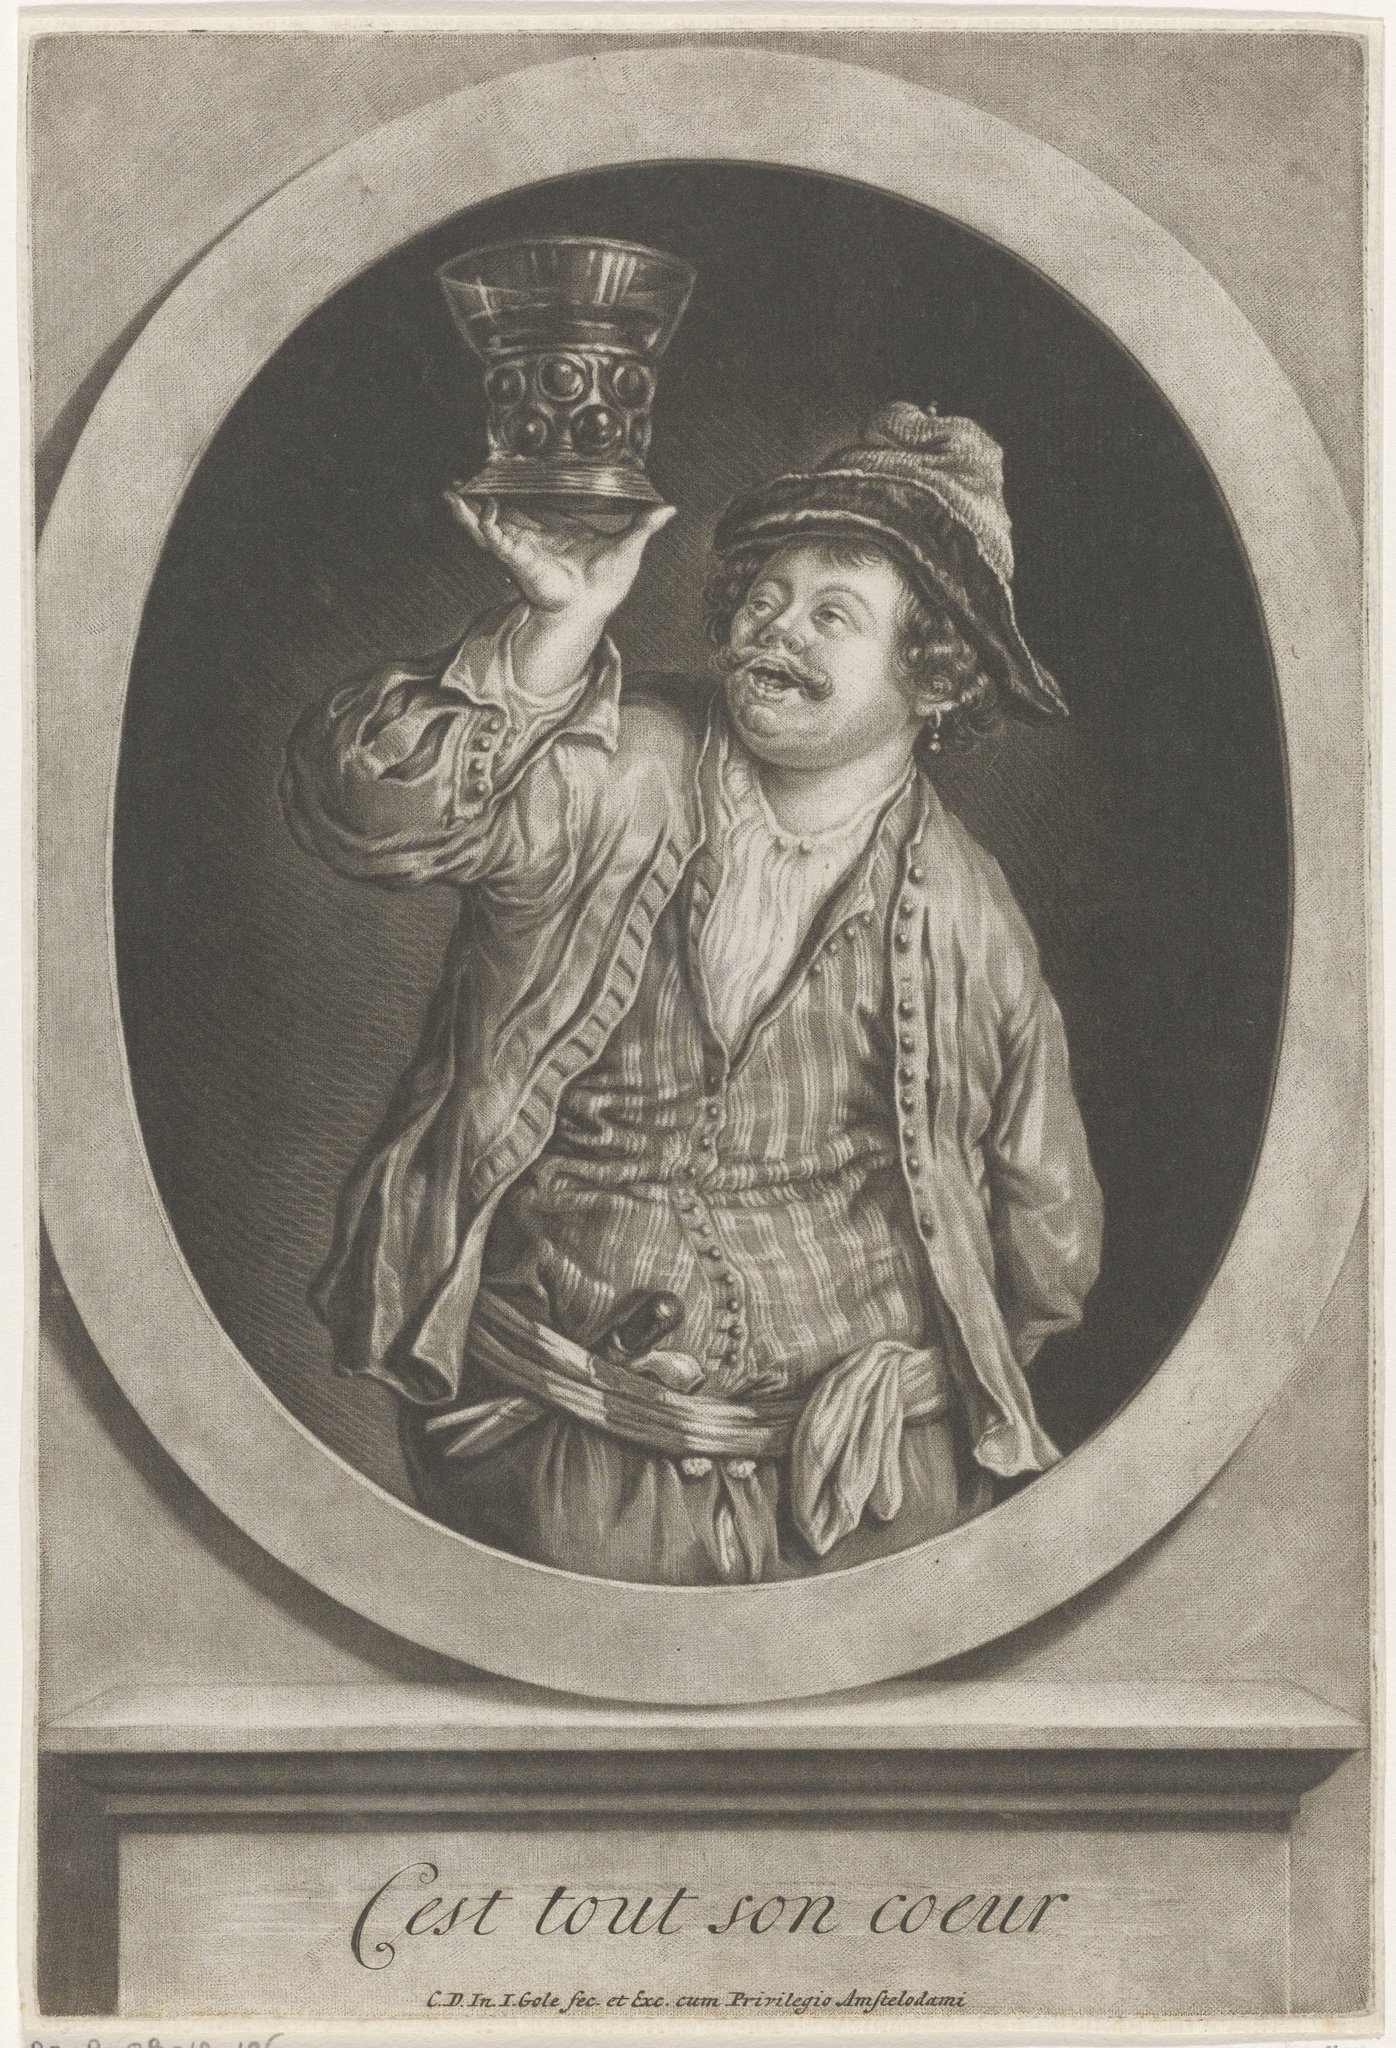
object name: print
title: Man met een roemer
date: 1670-1724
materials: paper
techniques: engraving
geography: amsterdam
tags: rome, painter, draughtsman, jan van mieris, head-gear: hat (+ men's clothes), glass, rummer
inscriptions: collector's mark: Lugt 240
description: Een jonge man met in de hand een roemer en op het hoofd een muts. Mogelijk Jan van Mieris.